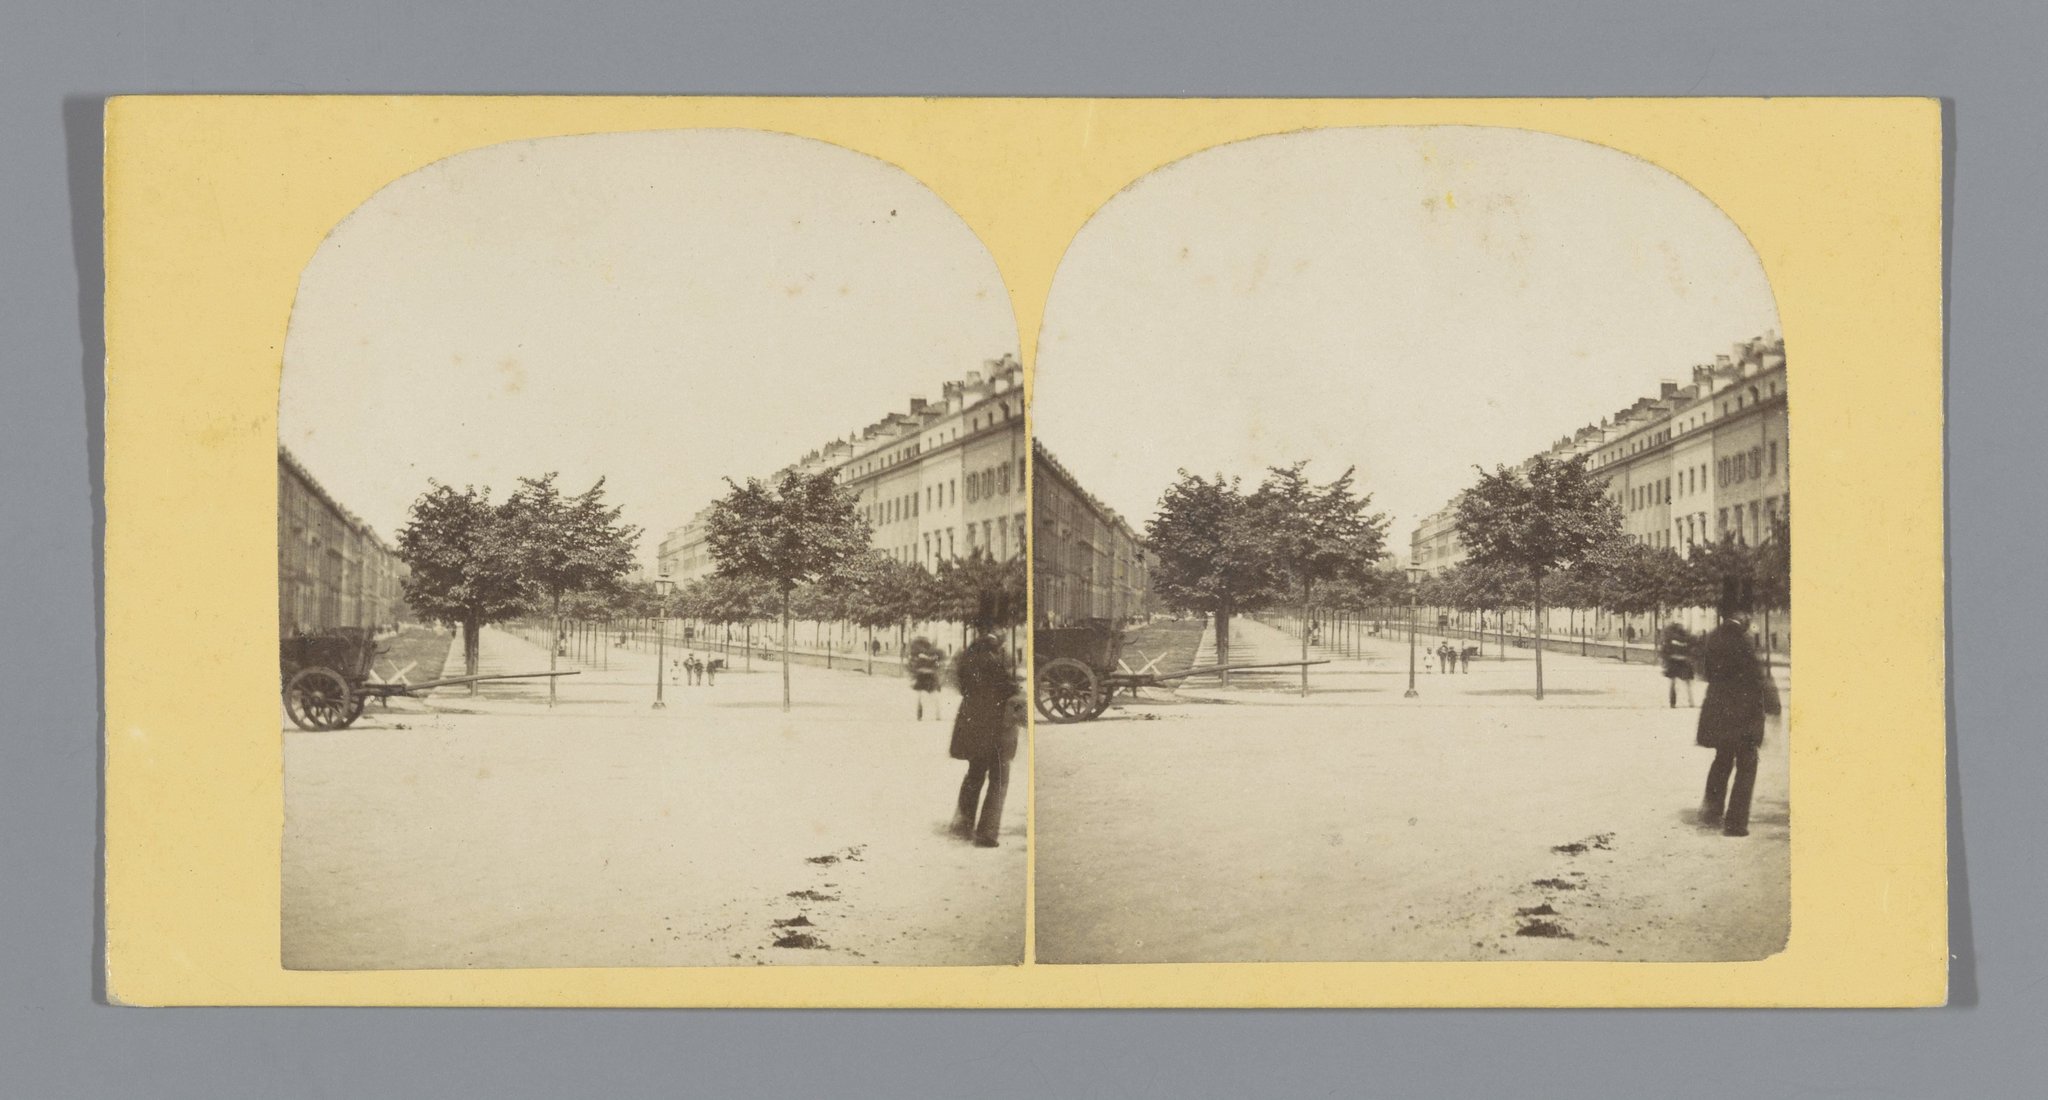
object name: stereograph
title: Gezicht op de Esplanade te Hamburg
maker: Anonymous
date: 1860-1885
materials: cardboard, photographic support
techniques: albumen print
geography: esplanade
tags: esplanade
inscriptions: inscription: ‘Esplanade’